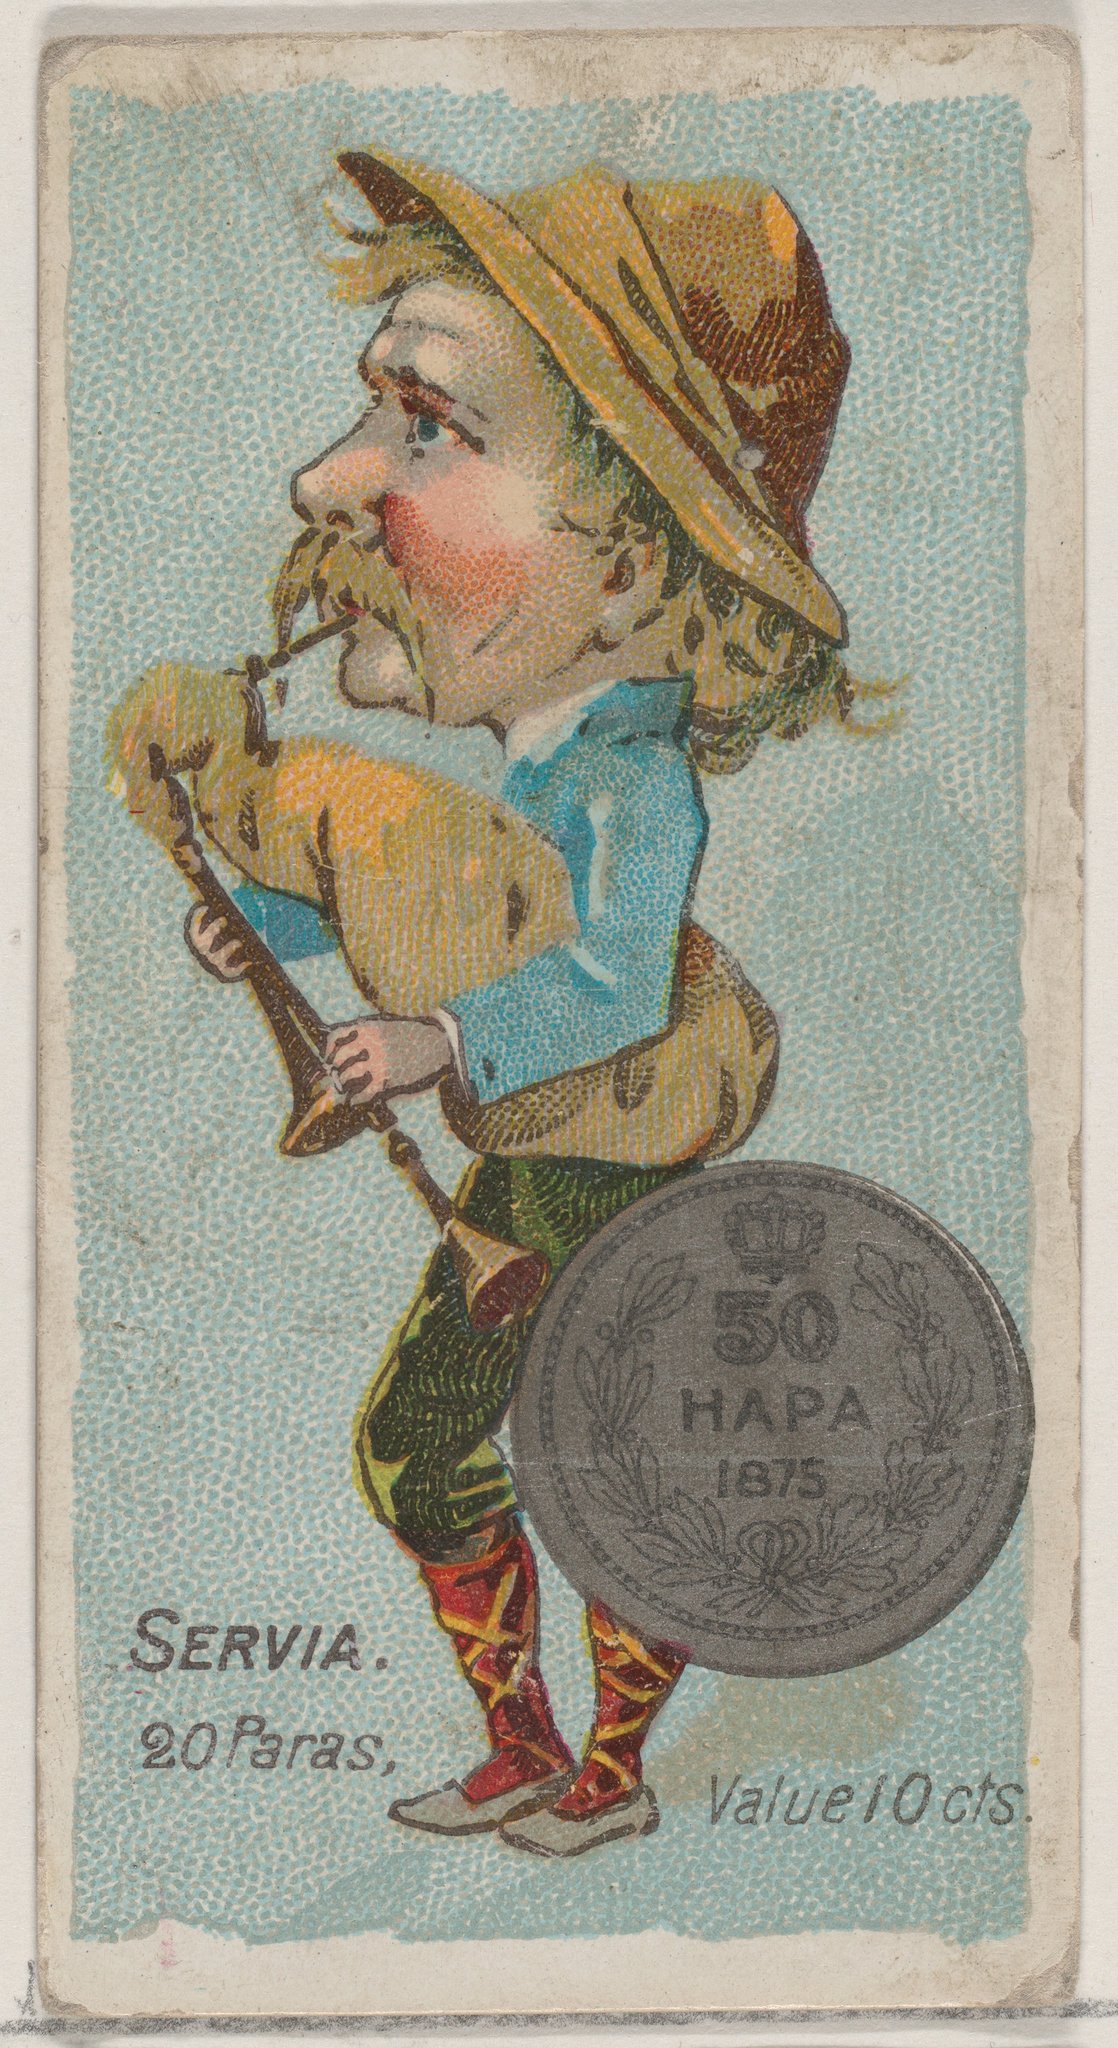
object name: print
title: Servia, 20 Paras, from the series Coins of All Nations (N72, variation 2) for Duke brand cigarettes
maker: w. duke, sons & co.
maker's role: publisher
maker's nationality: american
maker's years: 1870-1920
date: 1889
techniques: color lithograph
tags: men,bagpipes,coins